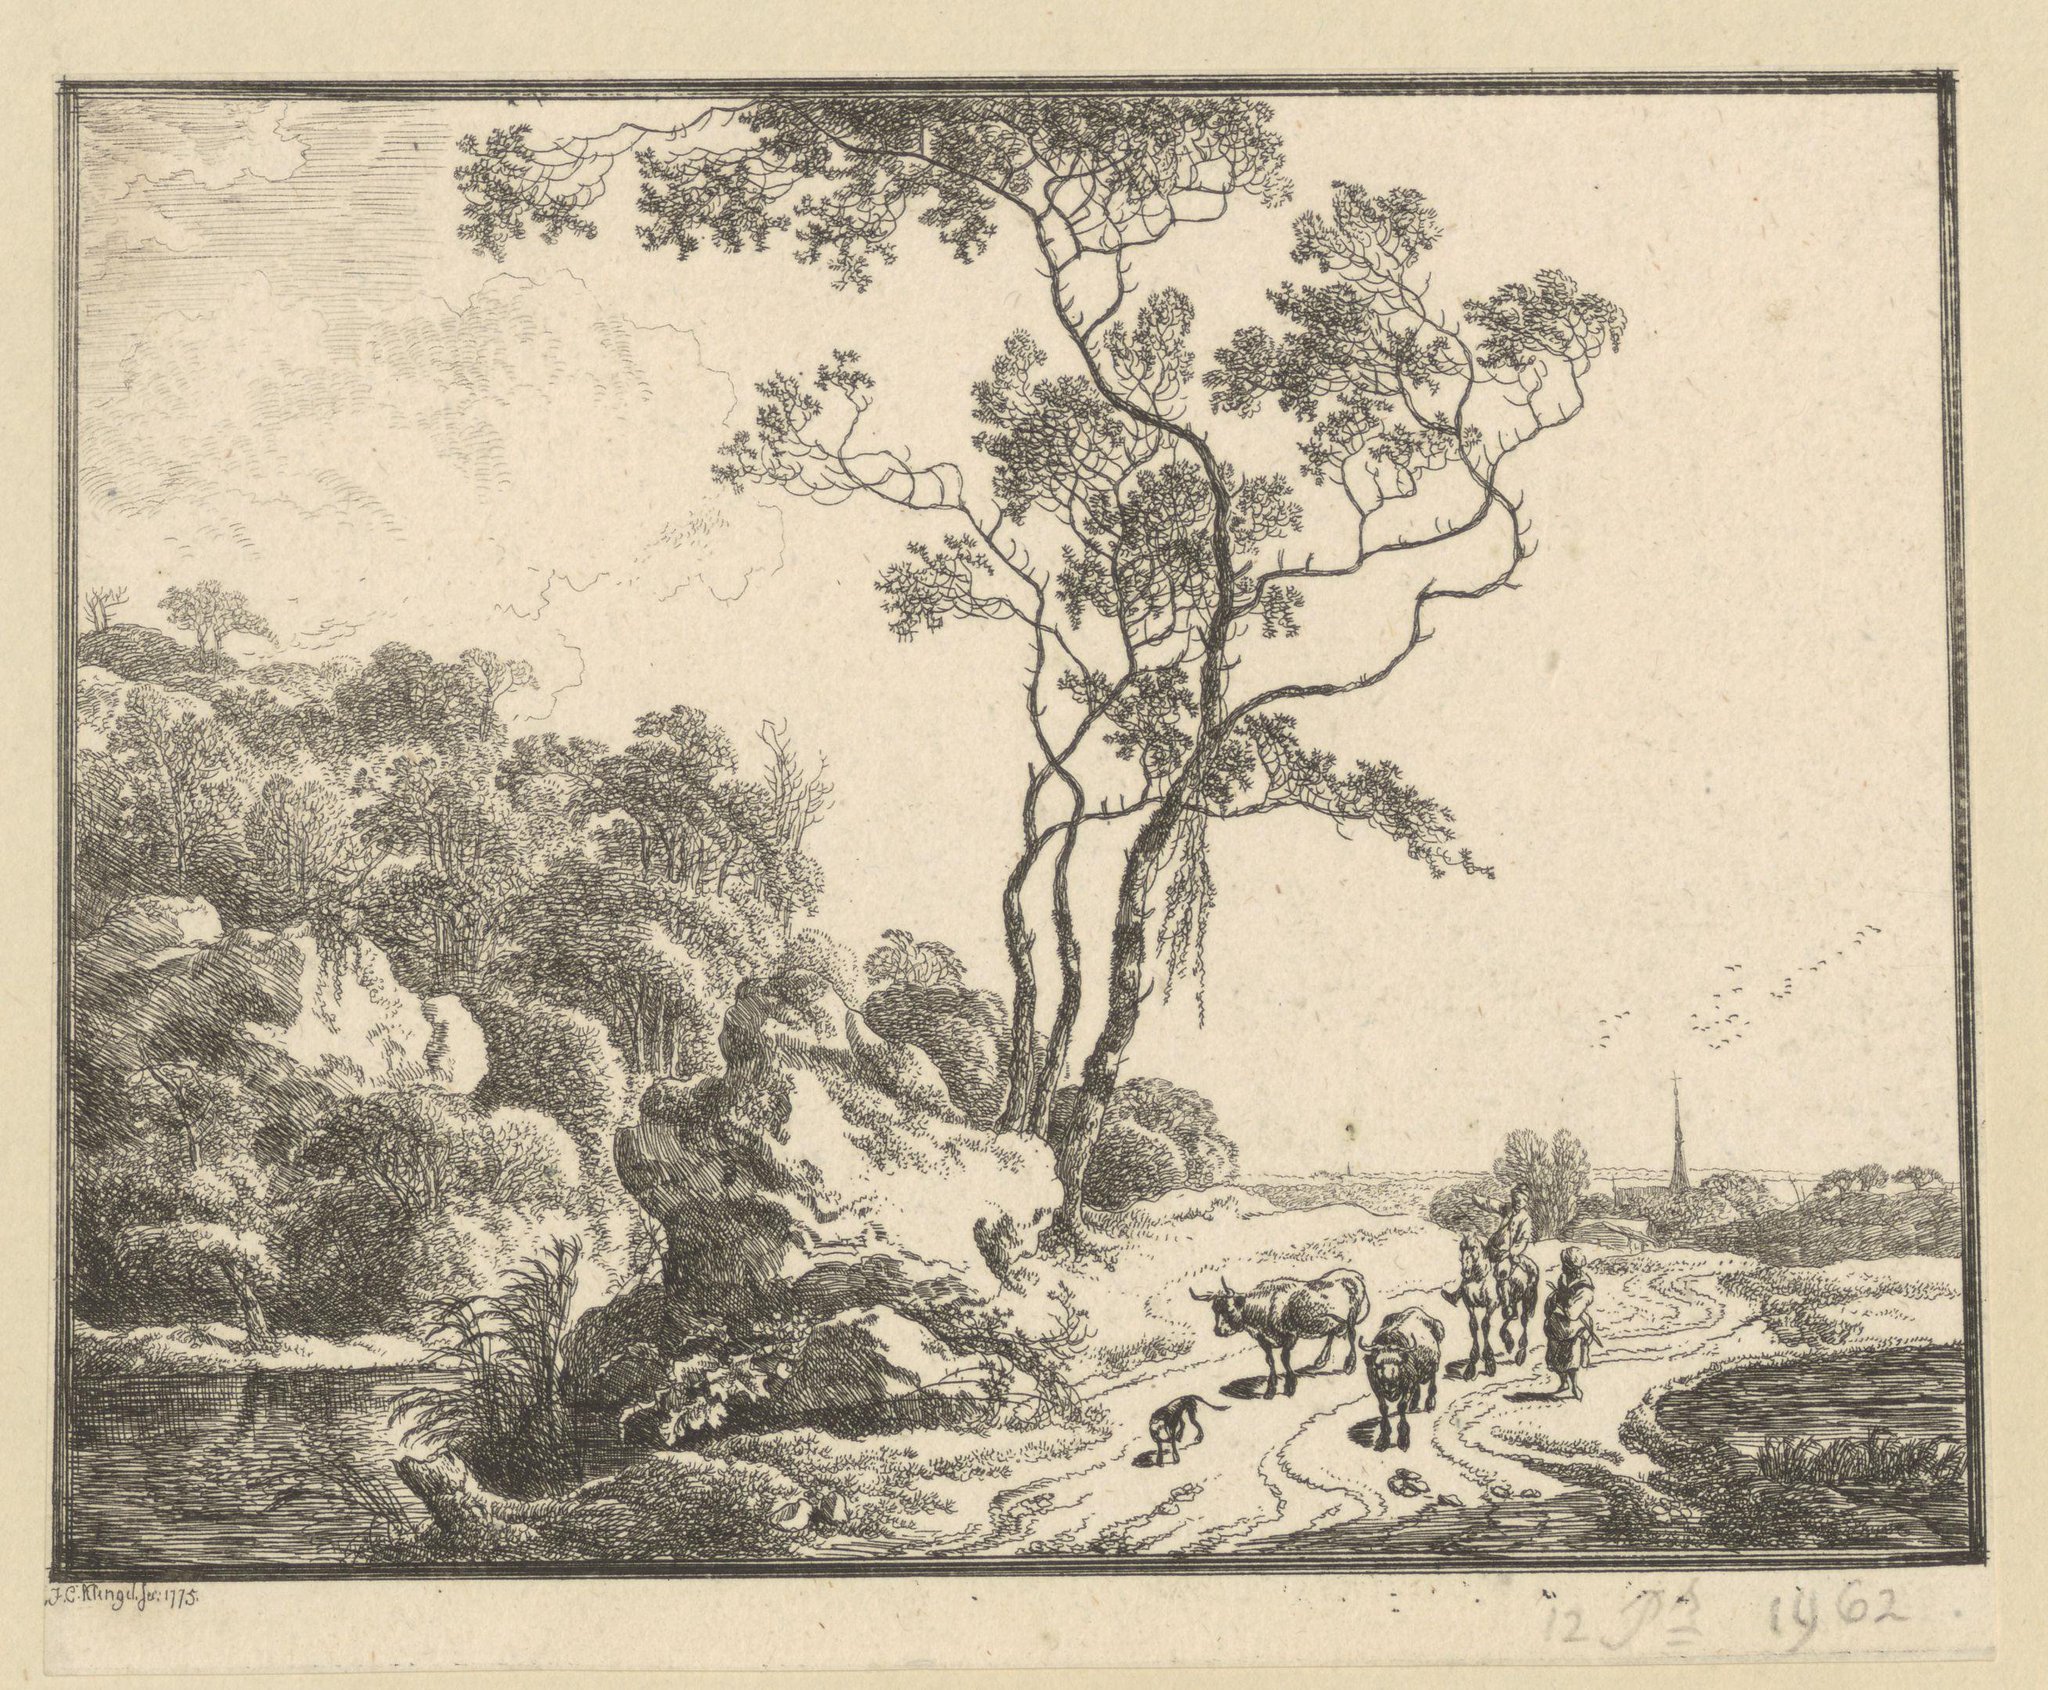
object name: print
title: Landschap met ruiter en herder met twee runderen bij een boom met klimplanten aan het water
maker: johann christian klengel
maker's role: print maker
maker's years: 1751-1824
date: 1775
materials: paper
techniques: etching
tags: herding, herdsman, herdswoman, shepherd, shepherdess, cowherd, etc., boulder, stone, towing path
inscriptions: collector's mark: Lugt 240